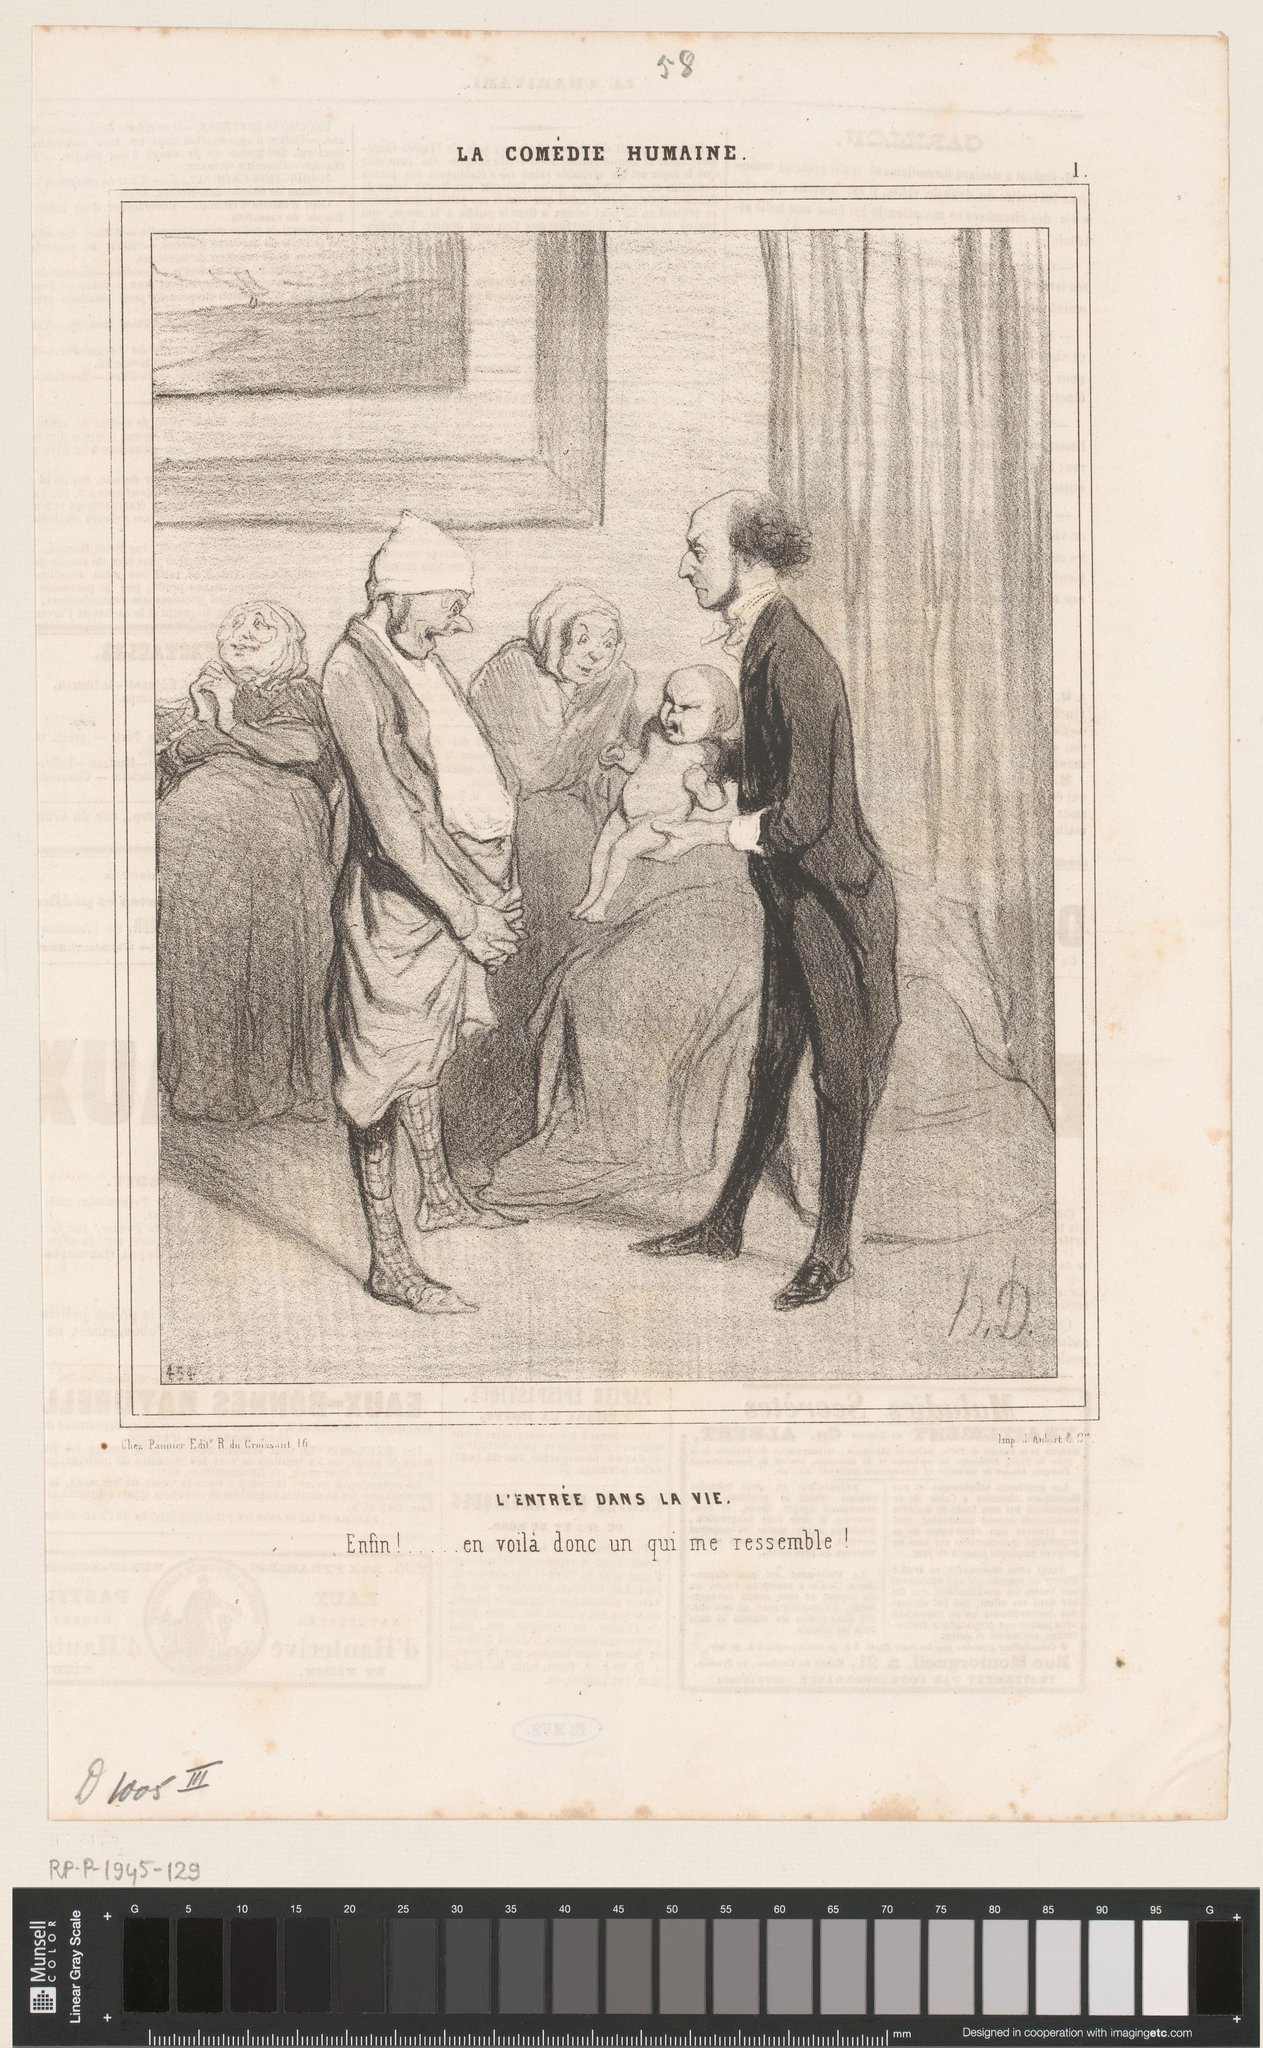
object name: cartoon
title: Dokter toont een vader zijn pasgeboren kind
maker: honoré daumier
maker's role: draughtsman, painter, print maker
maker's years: 1808-1879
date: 1843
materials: paper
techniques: lithograph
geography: paris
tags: caricatures (human types), the new-born child, infant, baby ~ the ages of man, father and child(ren), man and child(ren) (family group) (with number of children)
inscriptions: number: ‘58’, collector's mark: Lugt 2228a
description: Prent gepubliceerd in: Le Charivari, Aubert: Parijs, 22-01-1843. Le Charivari was een humoristische krant met karikaturen en (politieke) cartoons.